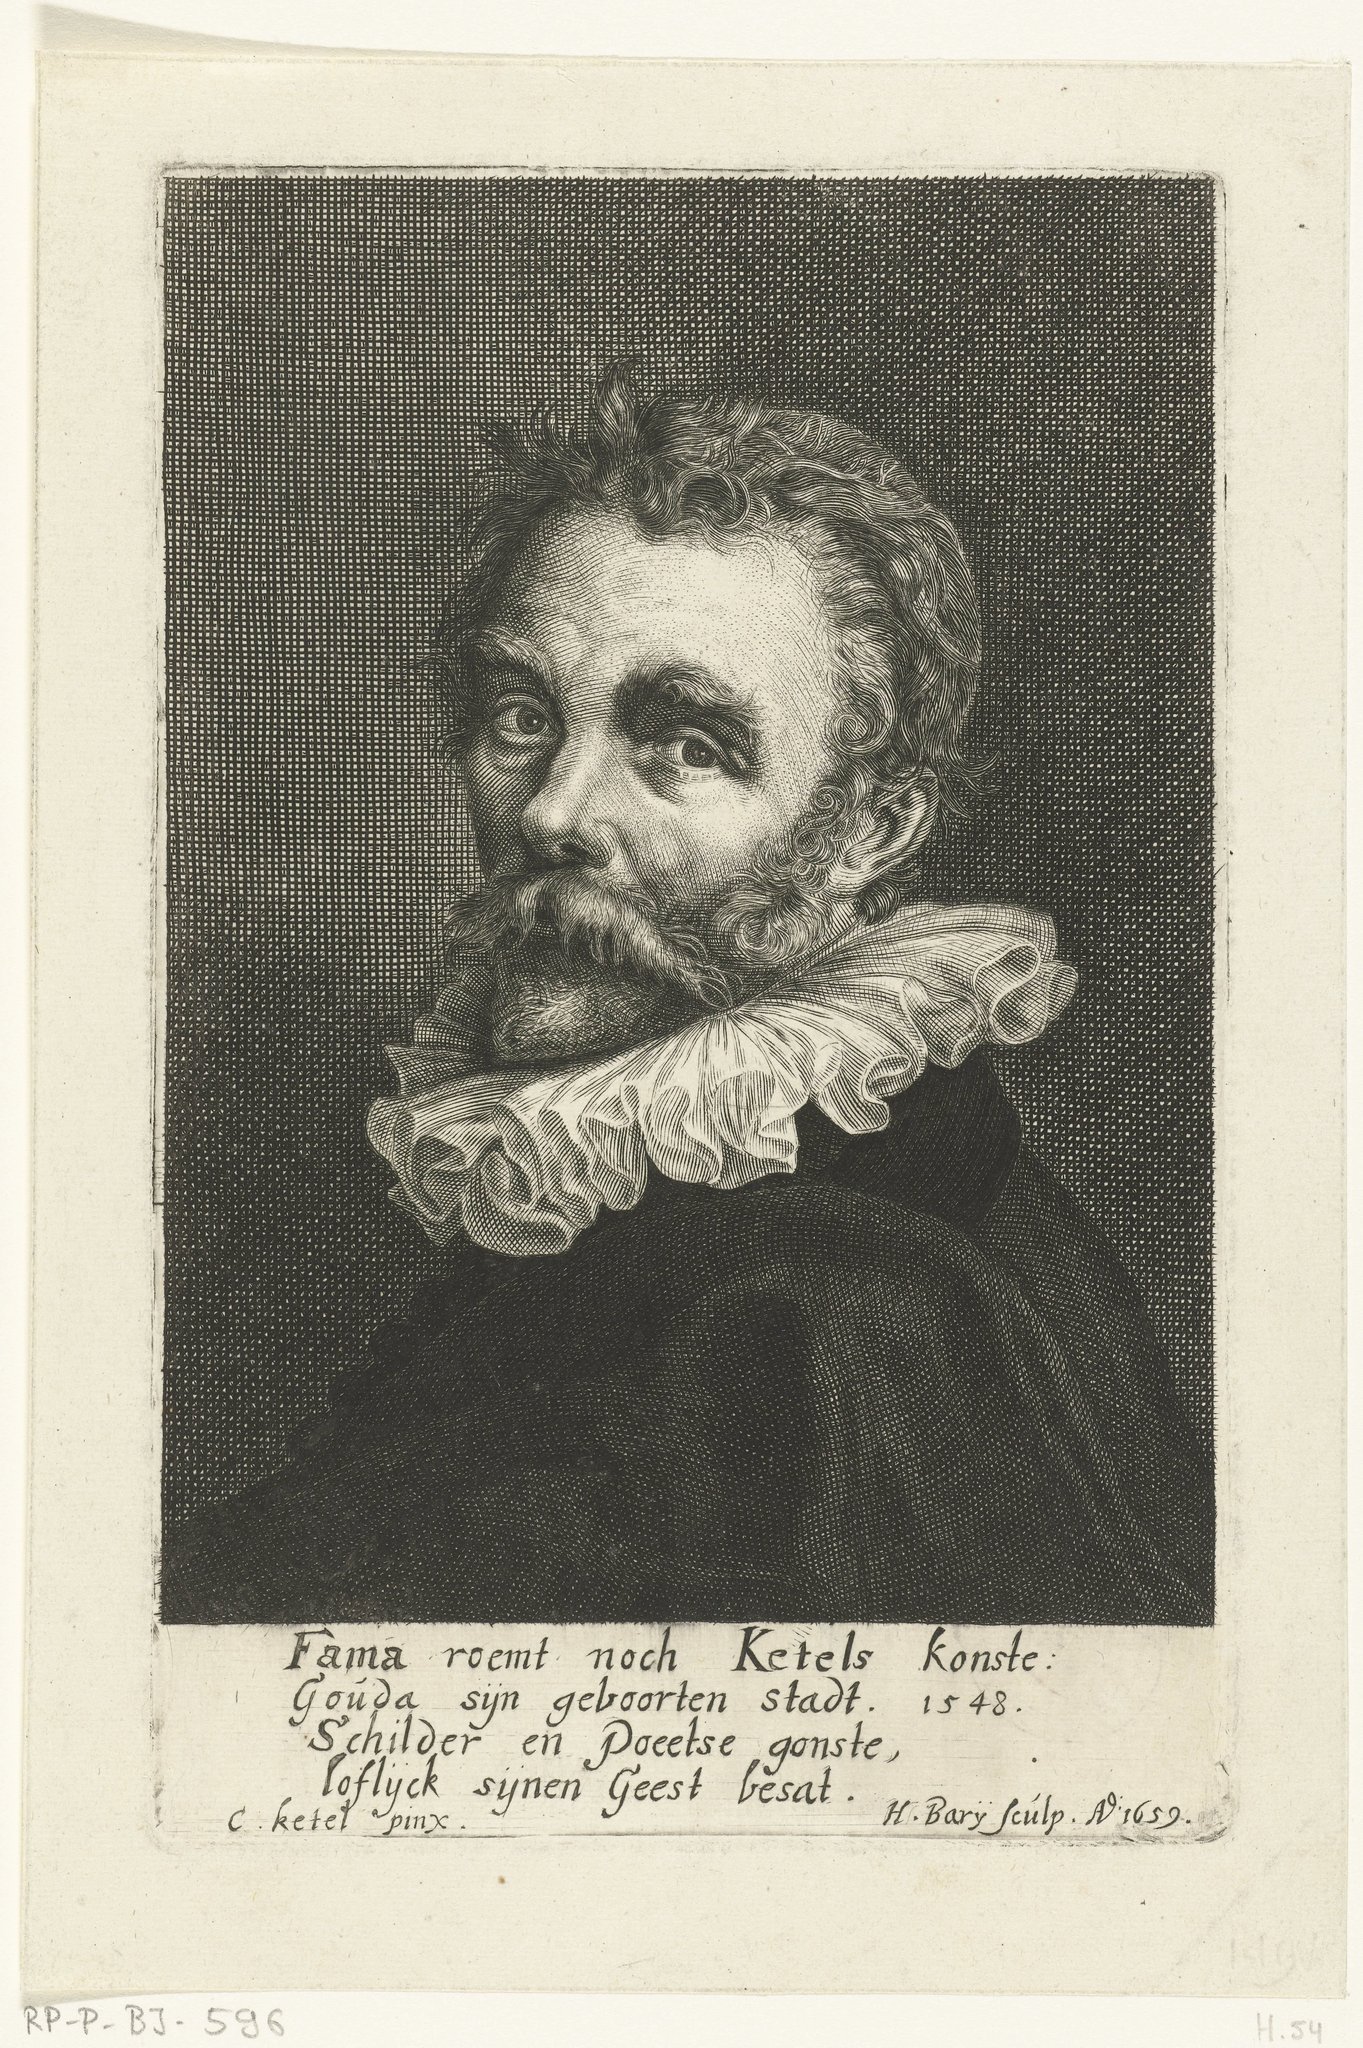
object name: print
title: Portret van Cornelis Ketel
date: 1659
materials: paper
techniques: engraving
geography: netherlands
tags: gouda, draughtsman, cornelis ketel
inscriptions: collector's mark: Lugt 240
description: Borstbeeld van Cornelis Ketel met een vers van vier regels op Ketel in het Nederlands.